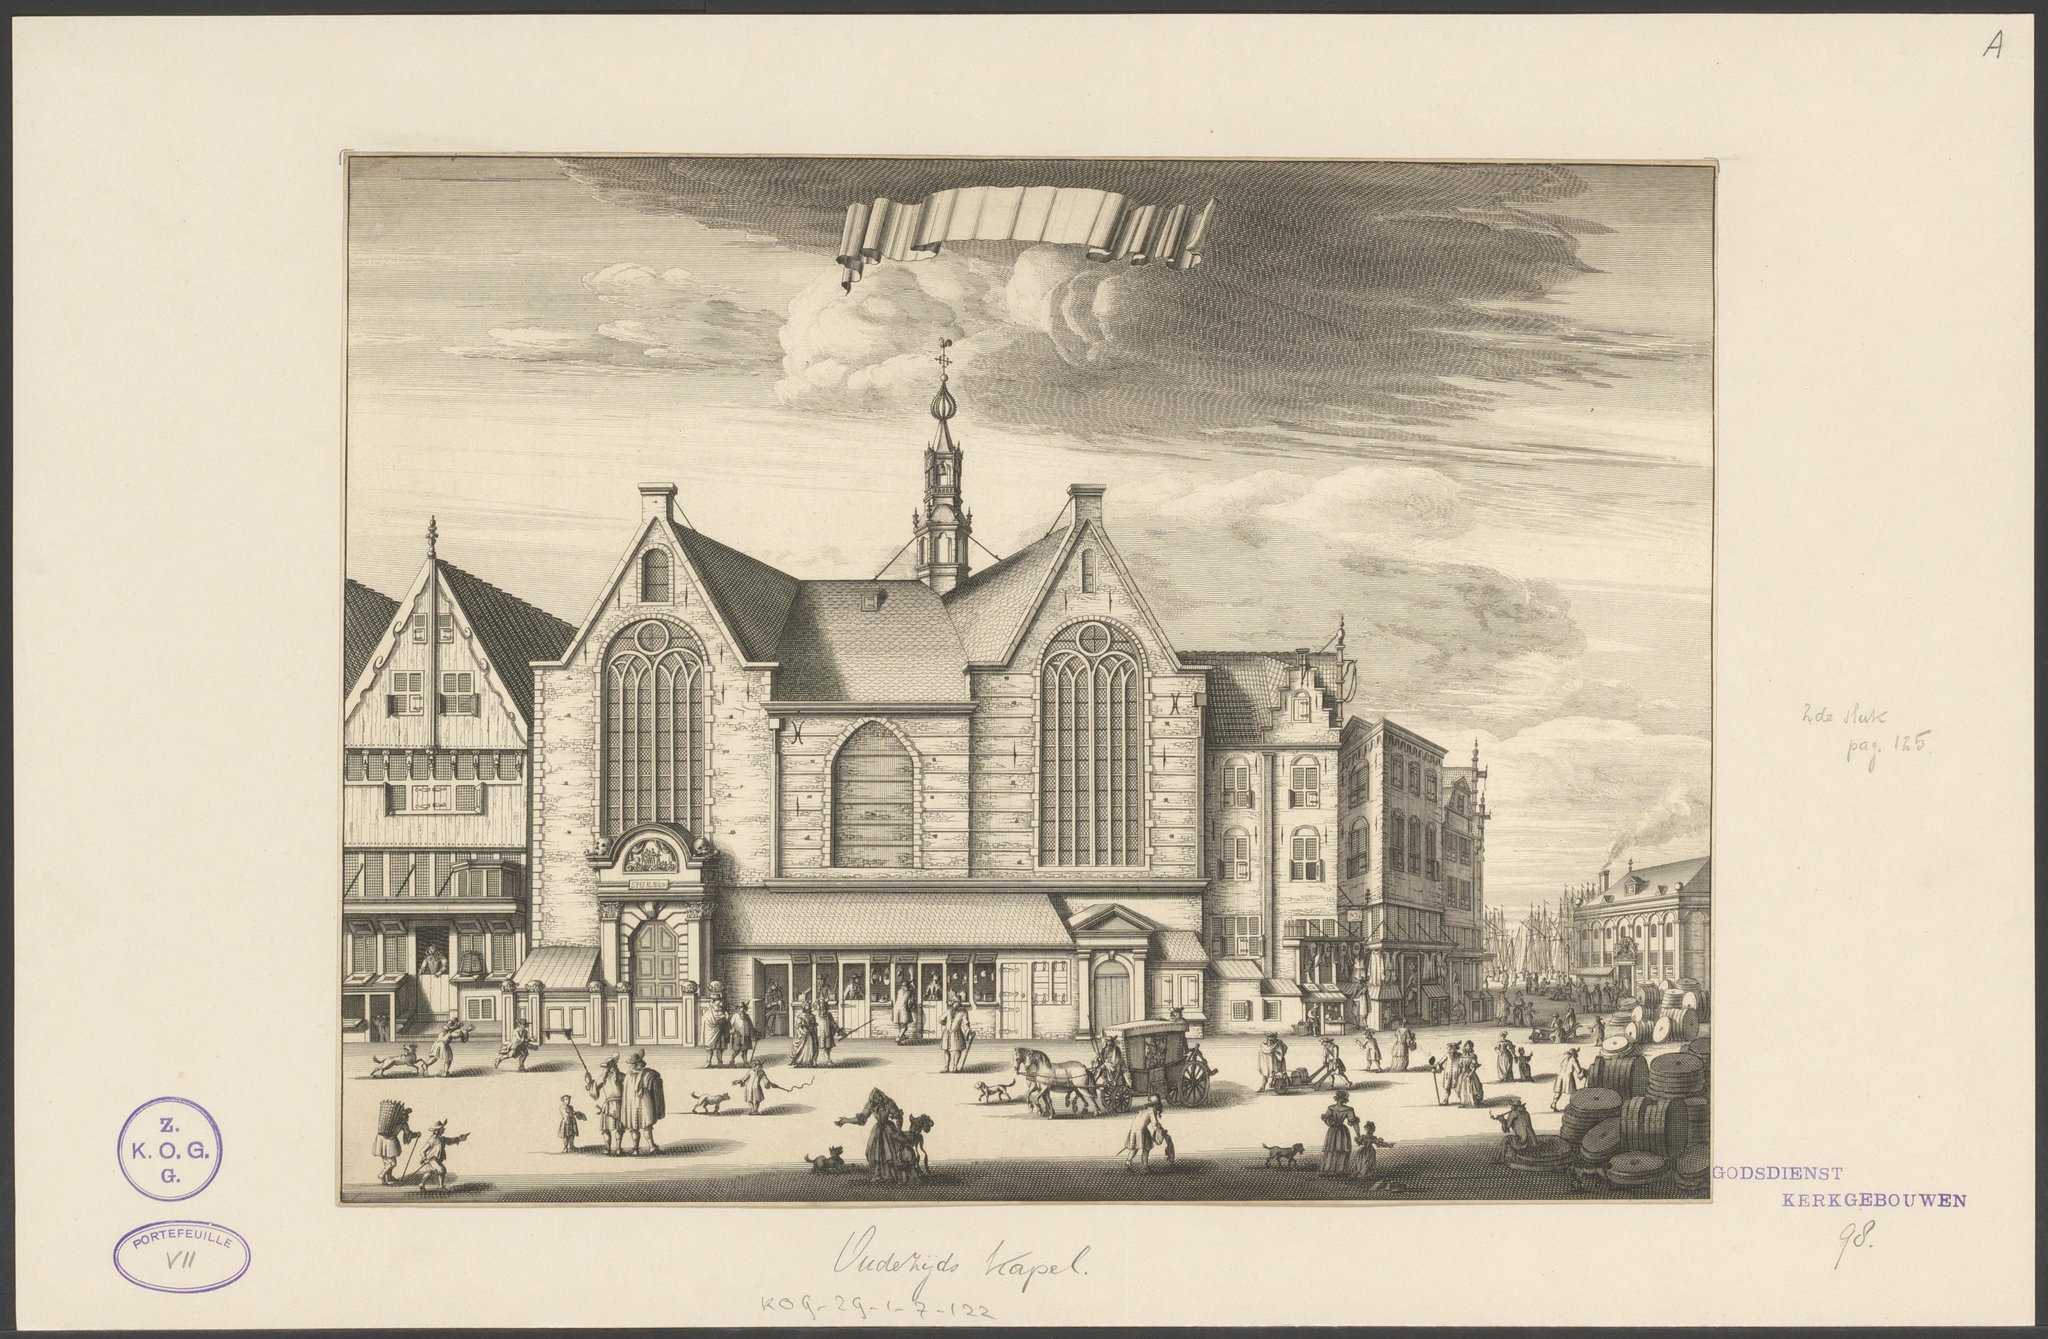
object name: print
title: Gezicht op de Sint-Olofskapel (Oudezijds Kapel) te Amsterdam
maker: Anonymous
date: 1693-1694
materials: paper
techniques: etching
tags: church (exterior), street (+ city(-scape) with figures, staffage)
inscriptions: collector's mark: Lugt 1641, stamp, stamp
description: Latere staten gebruikt in: Commelin, Caspar. Beschryvinge van Amsterdam, desselfs eerste oorspronk uyt den Huyse (…). Amsterdam: Abraham Wolfgang et al., 1693. Of uit: Commelin, Caspar. Beschryvinge van Amsterdam, zynde een naukeurige verhandelinge van desselfs eerste oorspronk uyt (…). Amsterdam: weduwe Aart Dircksz Oossaan, 1694. Latere staat gebruikt in: Commelin, Caspar. Beschryvinge van Amsterdam, zynde een naukeurige verhandelinge van desselfs eerste oorspronk uyt (…). Amsterdam: Andries van Damme et al., 1726.